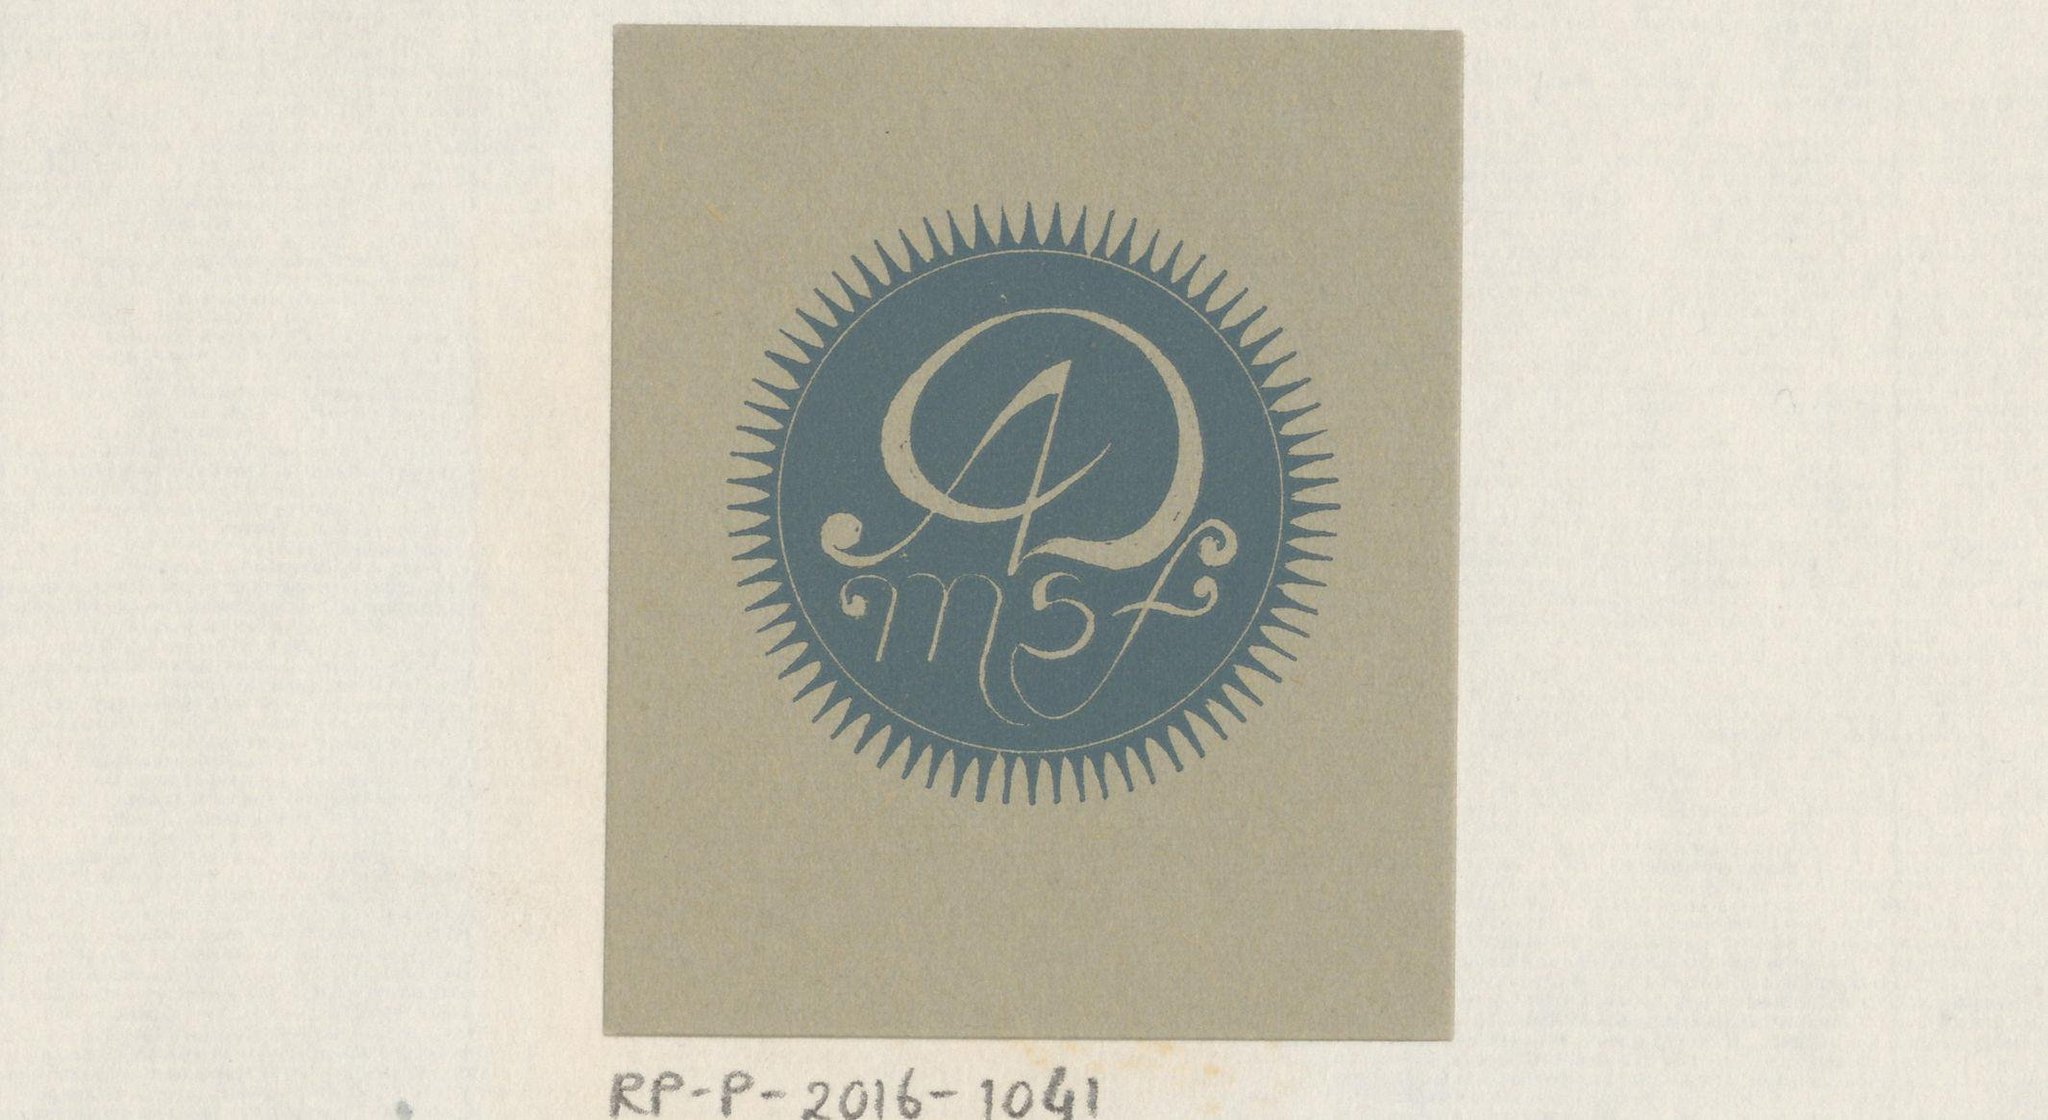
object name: bookplate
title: Ex libris van A.M.S.F.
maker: gerard bergman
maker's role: draughtsman, print maker, sculptor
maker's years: 1899-1980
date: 1949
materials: paper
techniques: engraving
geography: eindhoven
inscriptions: workshop stamp: ‘Houtgravure / G. Bergman / Jan v.d. Nootstr. 18 / Eindhoven Holland’